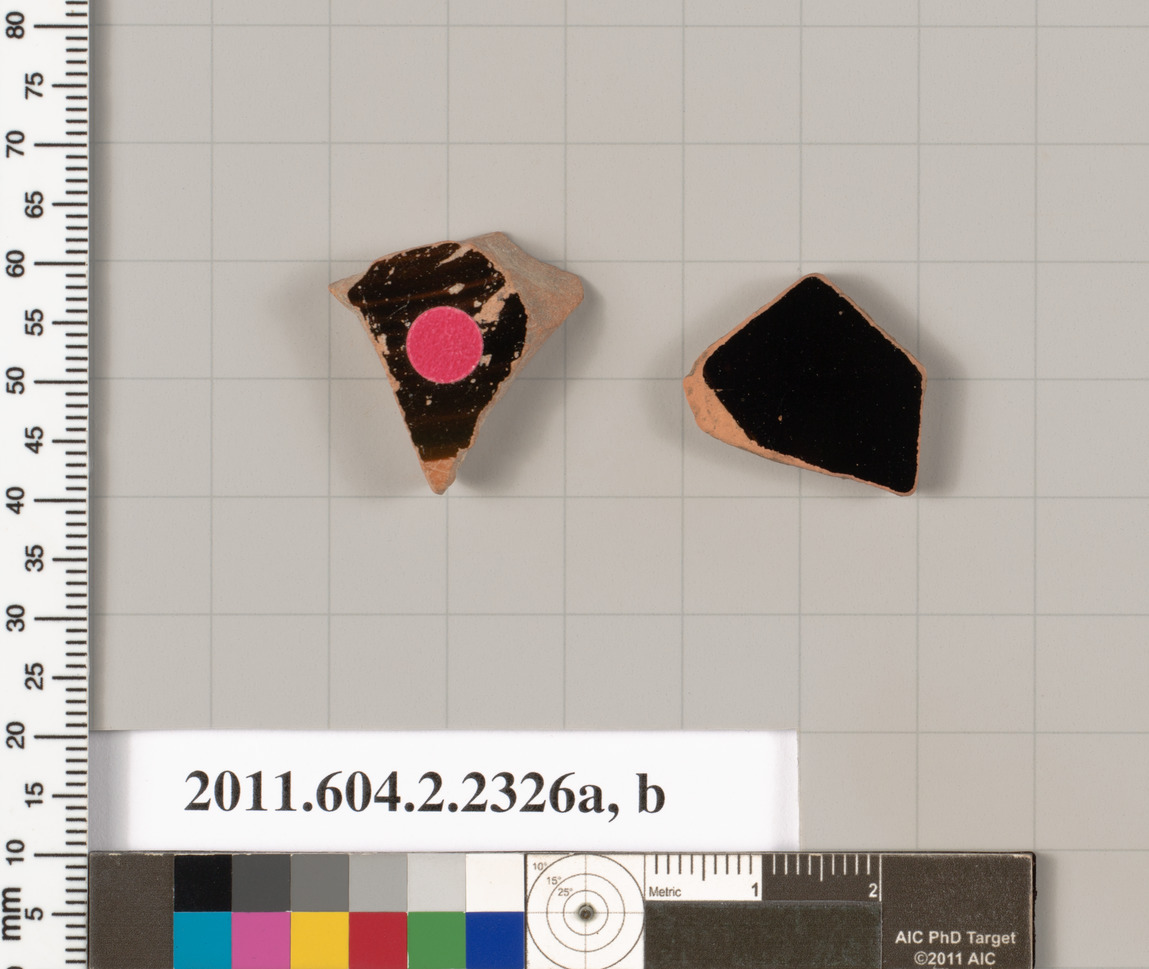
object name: skyphos fragment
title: Terracotta fragments of skyphoi (deep drinking cups)?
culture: greek, attic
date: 600-401 BCE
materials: terracotta